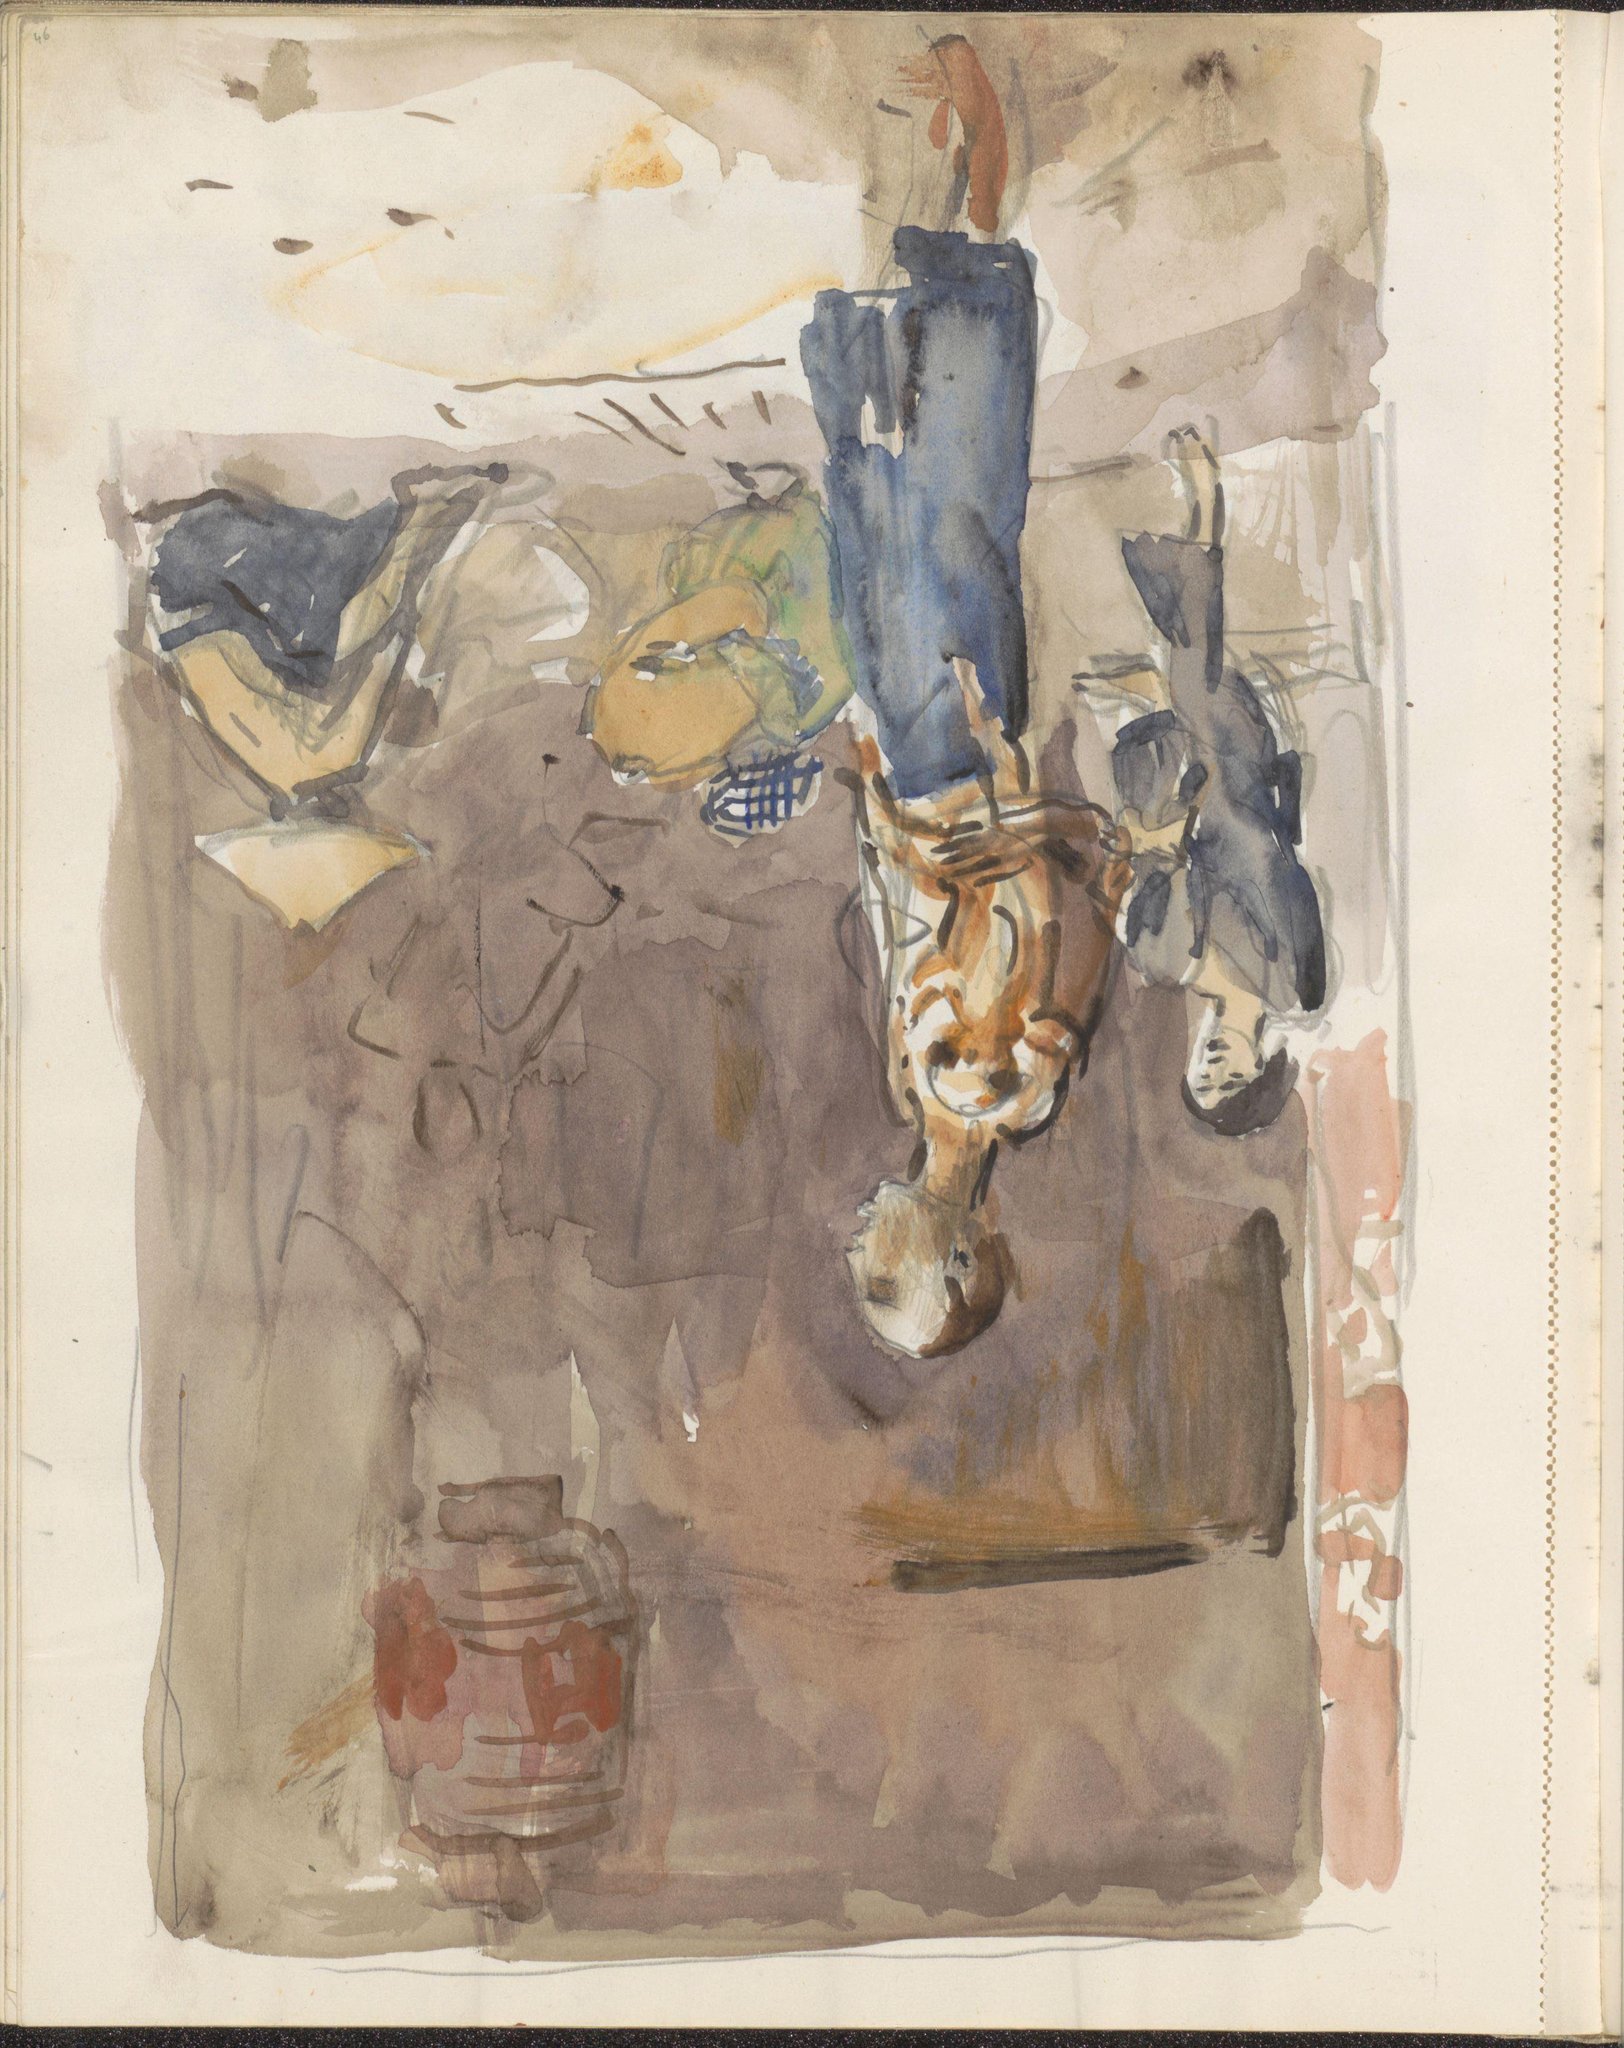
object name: sketchbook leaf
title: Straat met figuren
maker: marius bauer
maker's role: draughtsman, print maker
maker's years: 1867-1932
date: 1931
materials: paper, pencil, watercolor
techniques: brush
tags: street (+ city(-scape) with figures, staffage)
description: Pagina 46 uit een schetsboek met 48 bladen.